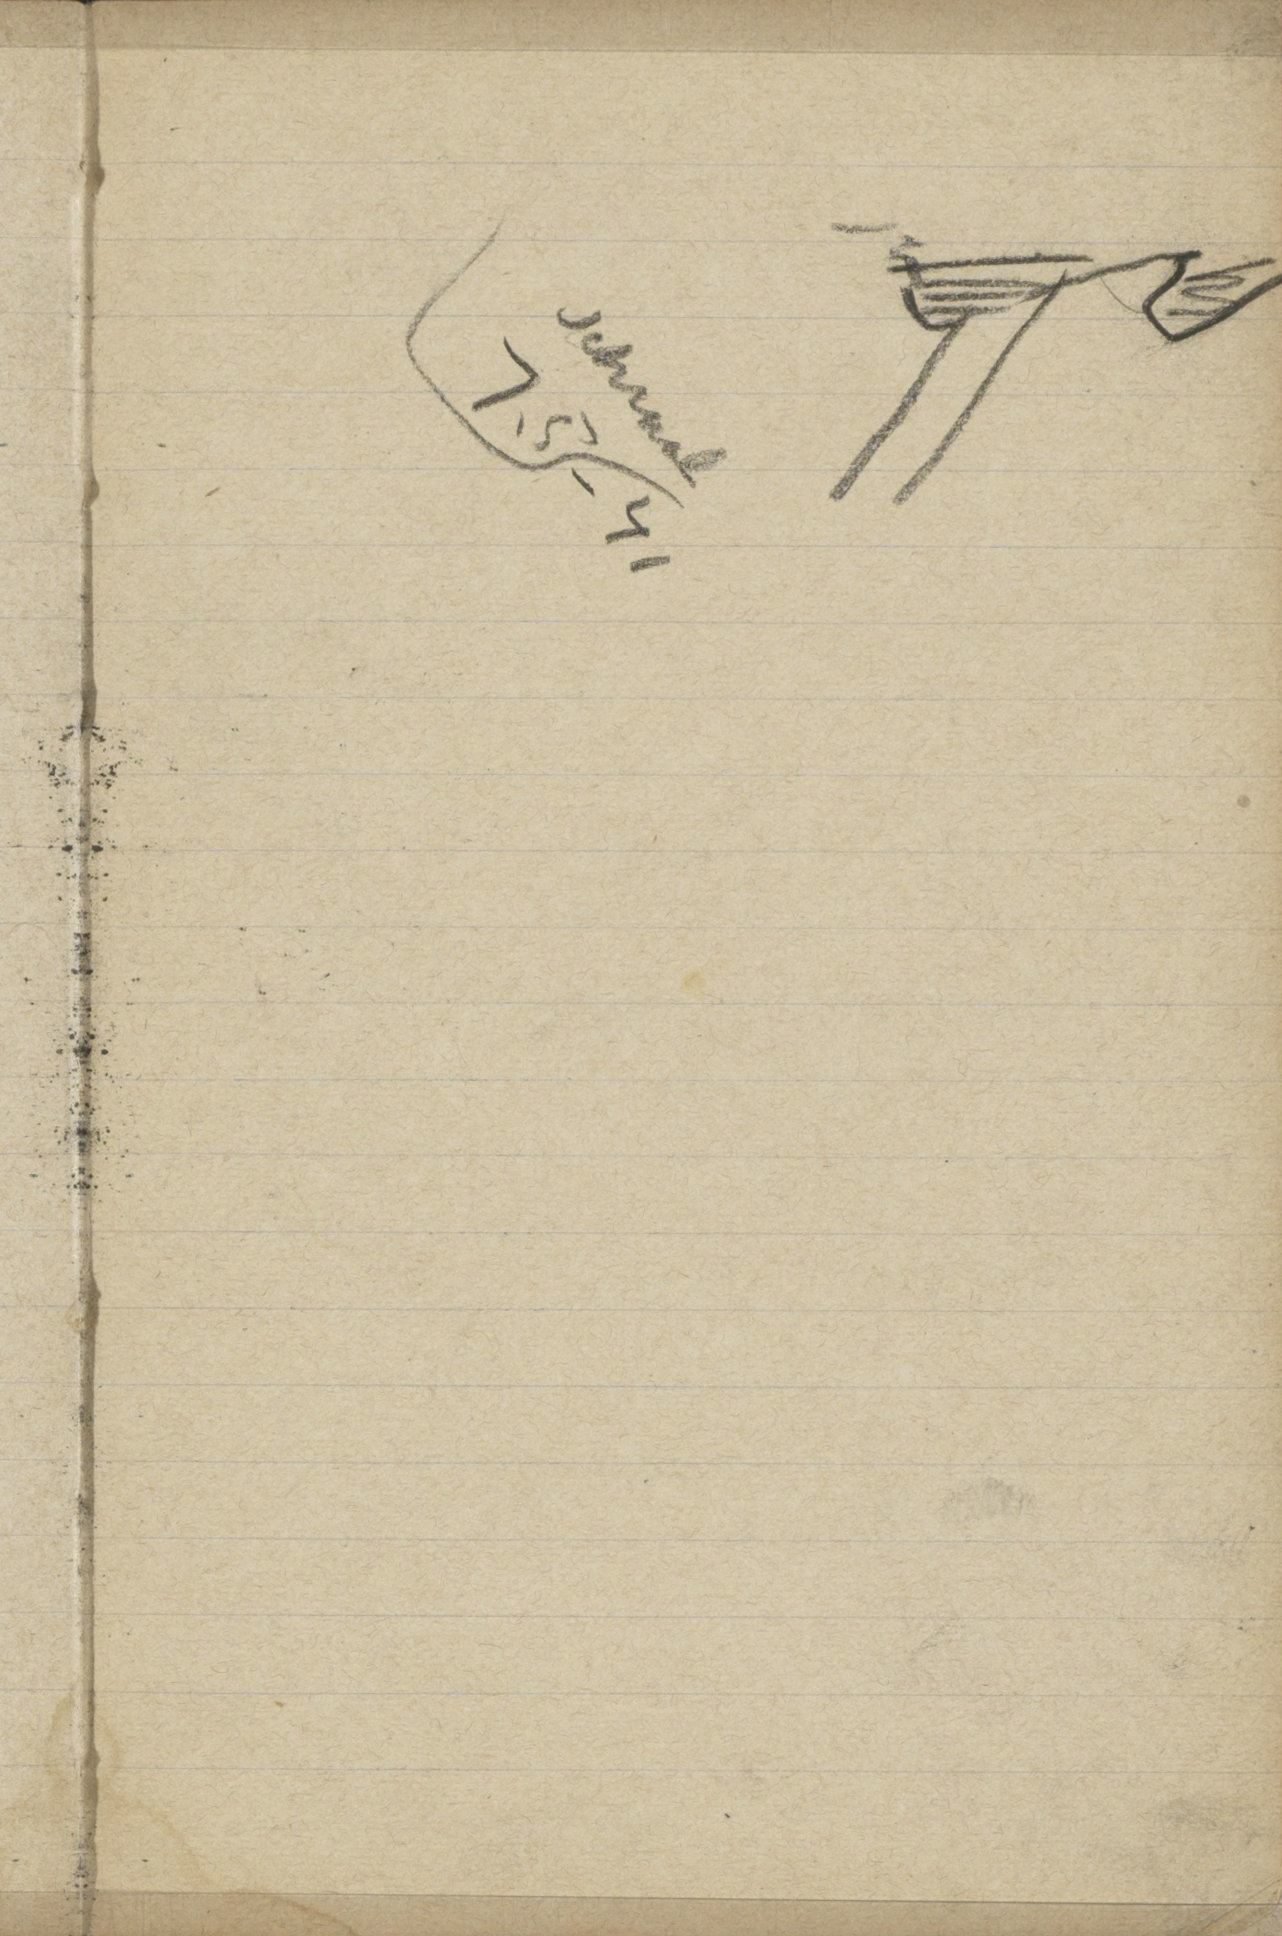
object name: sketchbook leaf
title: Studie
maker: george hendrik breitner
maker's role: draughtsman, painter, print maker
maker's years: 1857-1923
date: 1886-1903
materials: chalk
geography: amsterdam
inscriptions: annotation: ‘schraal[?]/ 7,5-41’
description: Pagina 46 uit een schetsboek met 41 bladen.